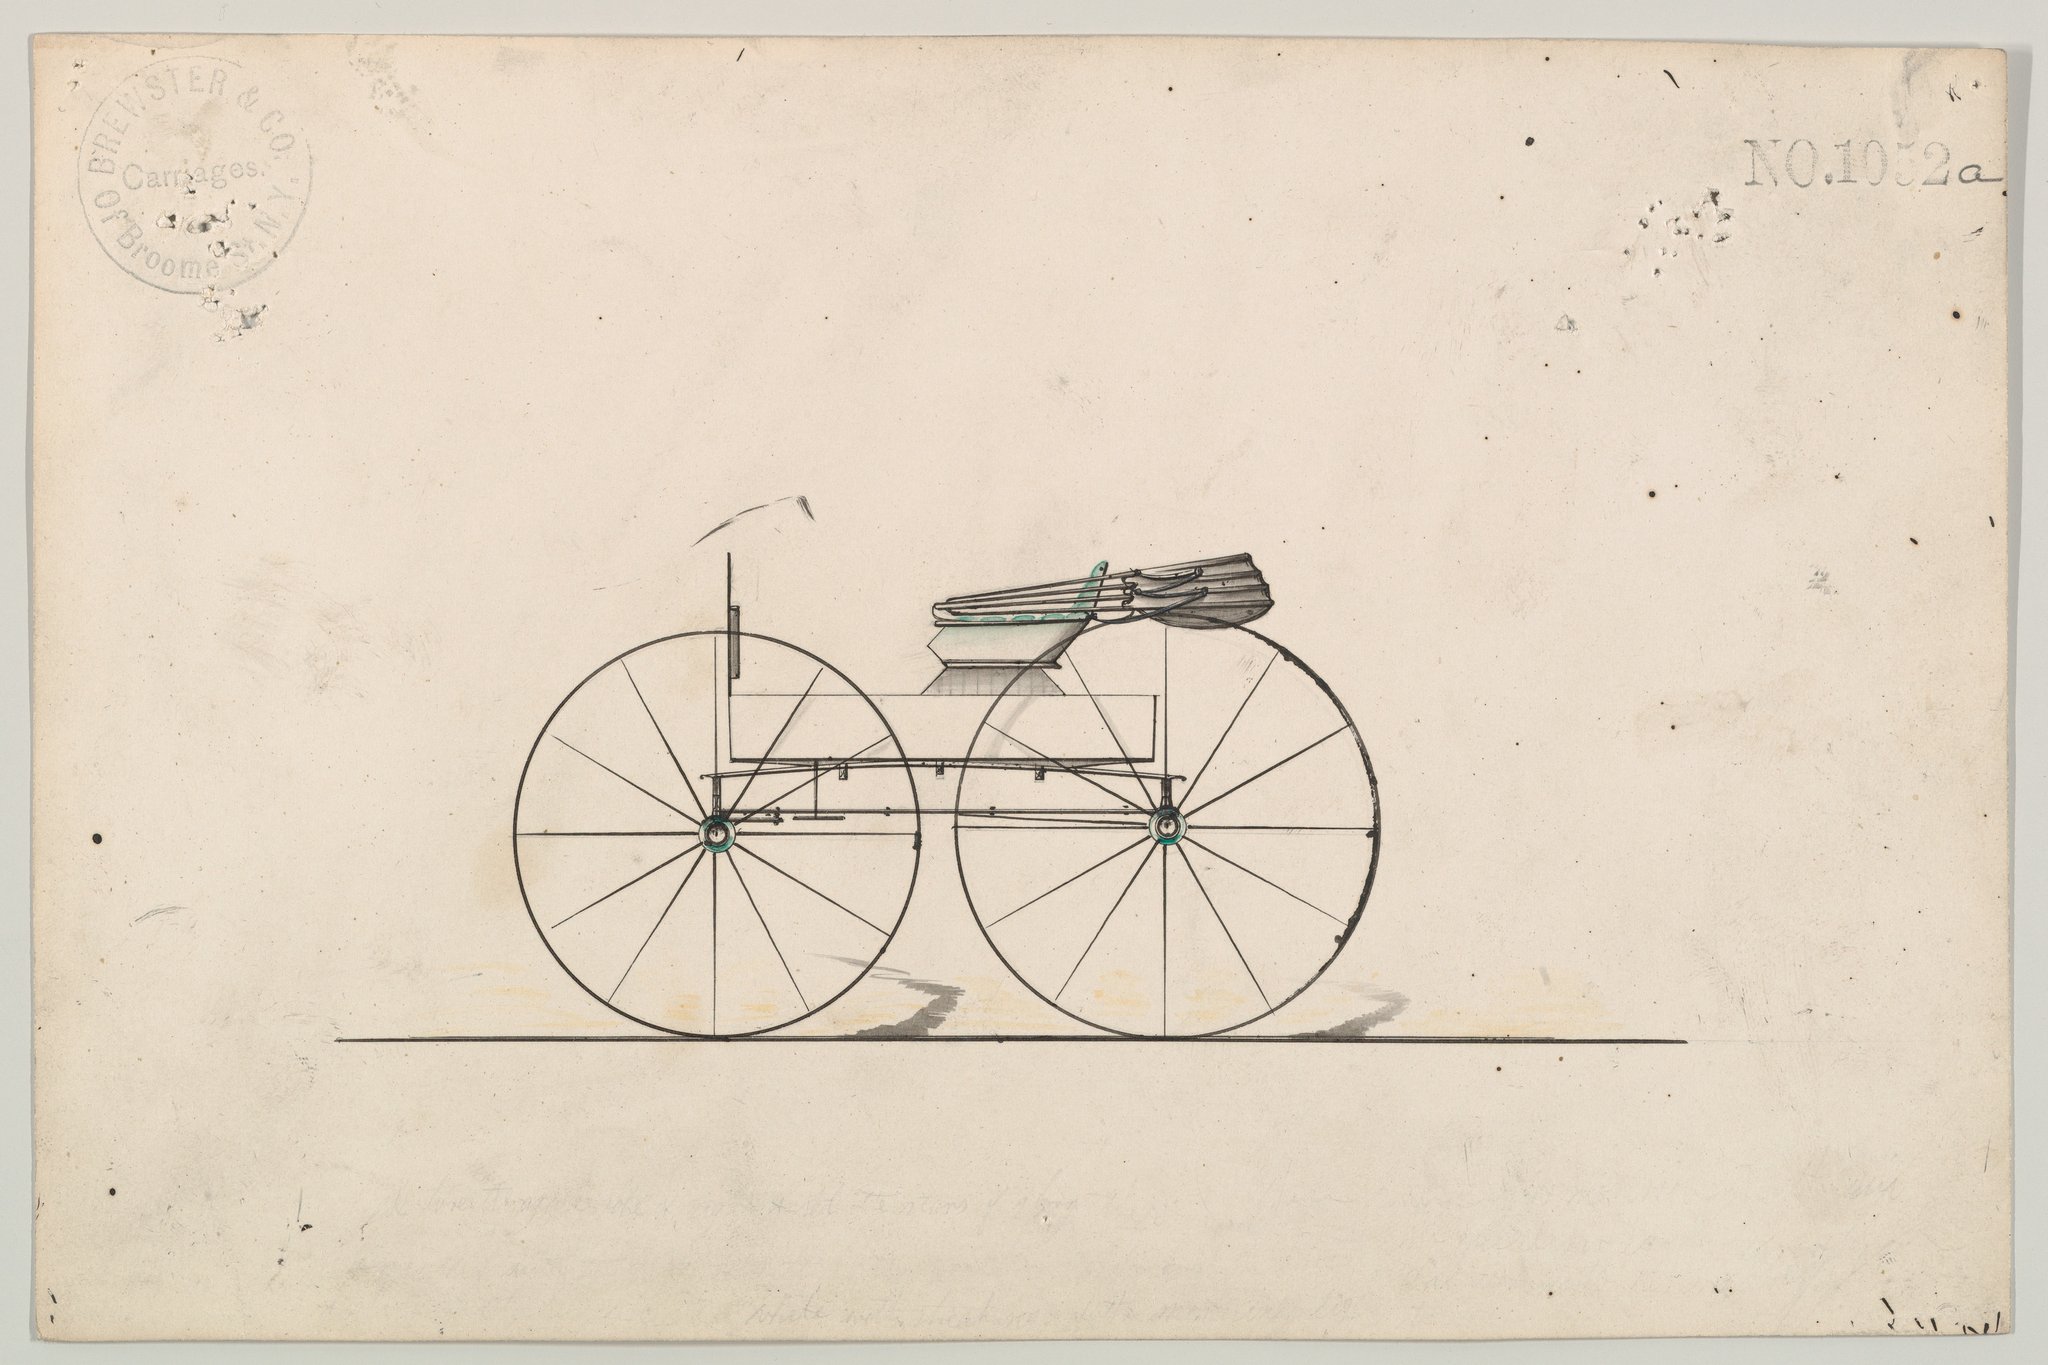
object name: drawing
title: Design for Wagon, no. 1052a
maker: brewster & co.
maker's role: manufacturer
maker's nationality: american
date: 1870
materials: gouache, ink, watercolor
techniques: pen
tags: carriages